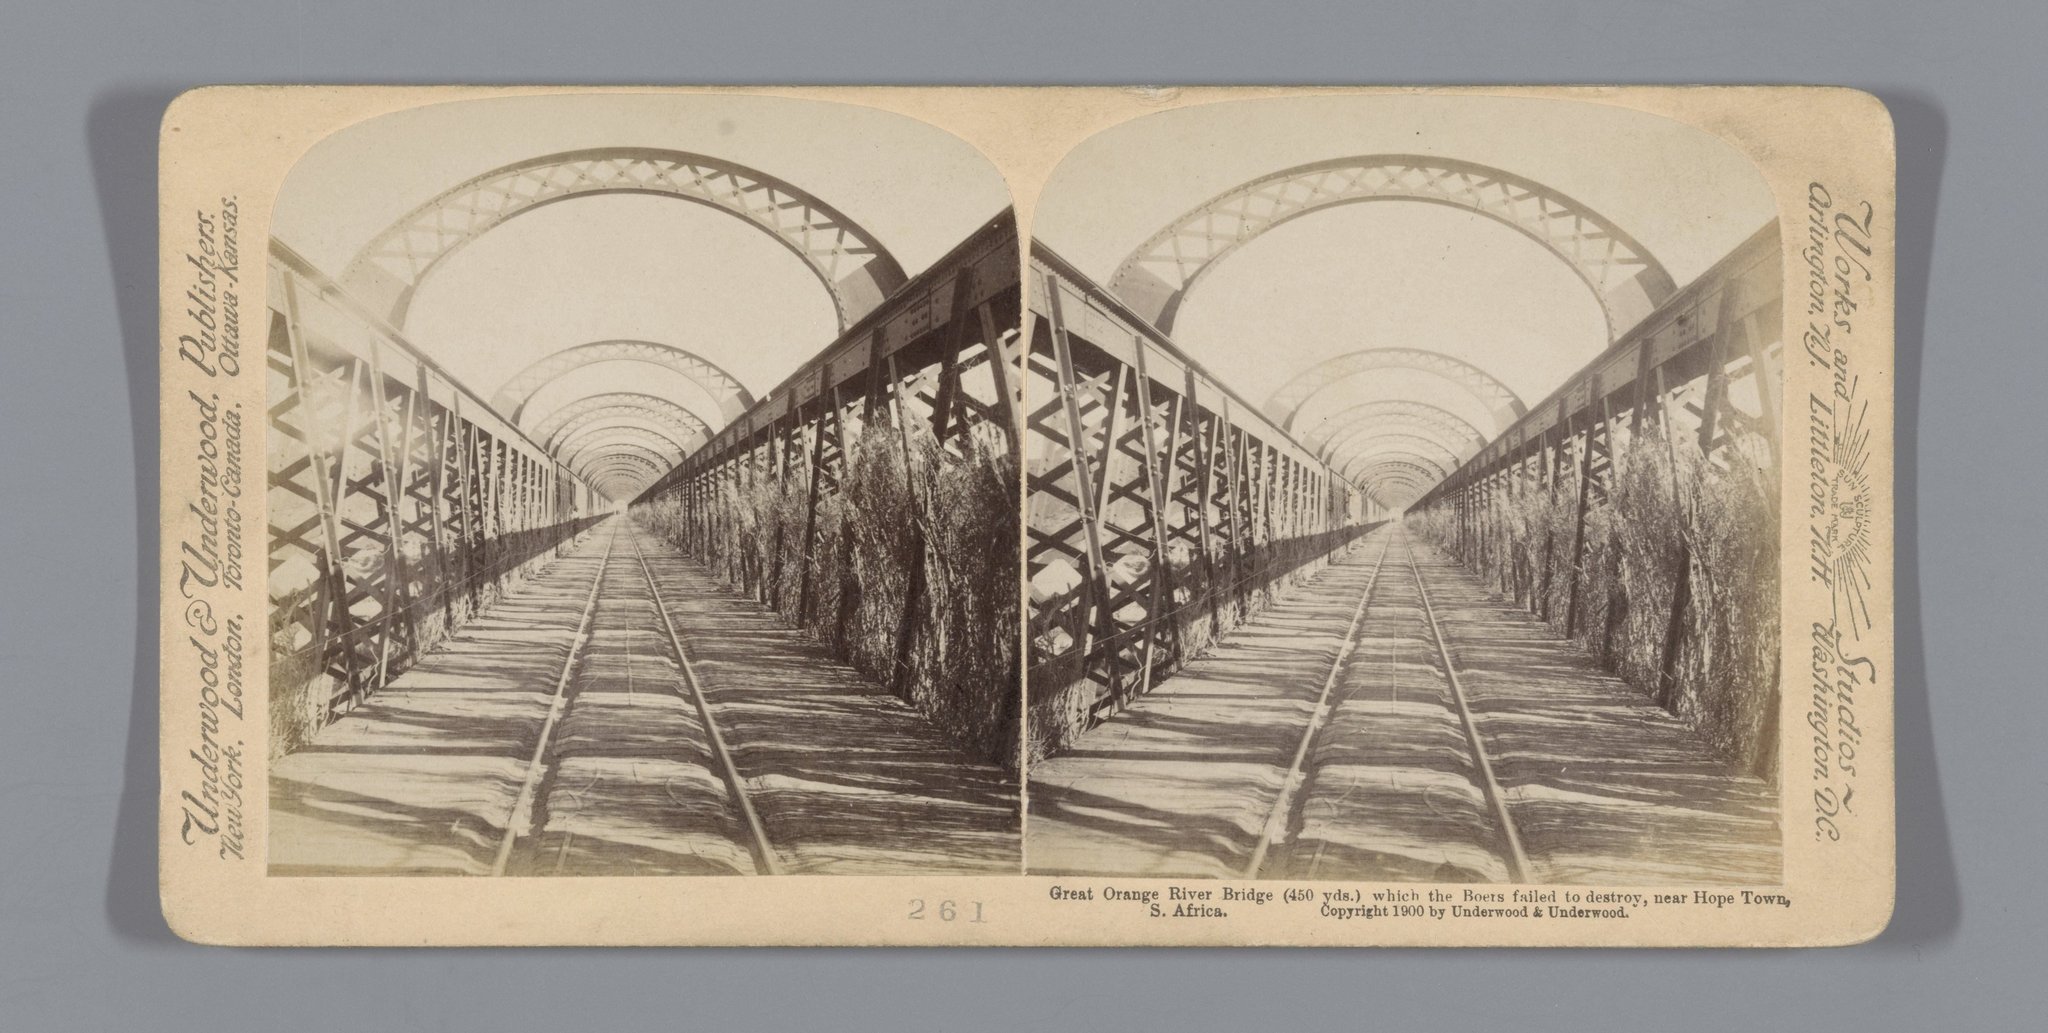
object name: stereograph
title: Spoorbrug over de Oranjerivier, nabij Hopetown, Zuid-Afrika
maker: Anonymous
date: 1900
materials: cardboard, paper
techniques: albumen print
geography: new york city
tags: railway, train, bridge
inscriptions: copyright notice: ‘Copyright 1900 by Underwood & Underwood.’, inscription: ‘Works and Studios ~/ Arlington, N.J. Littleton, N.H. Washington, D.C.’, inscription, number: ‘261’